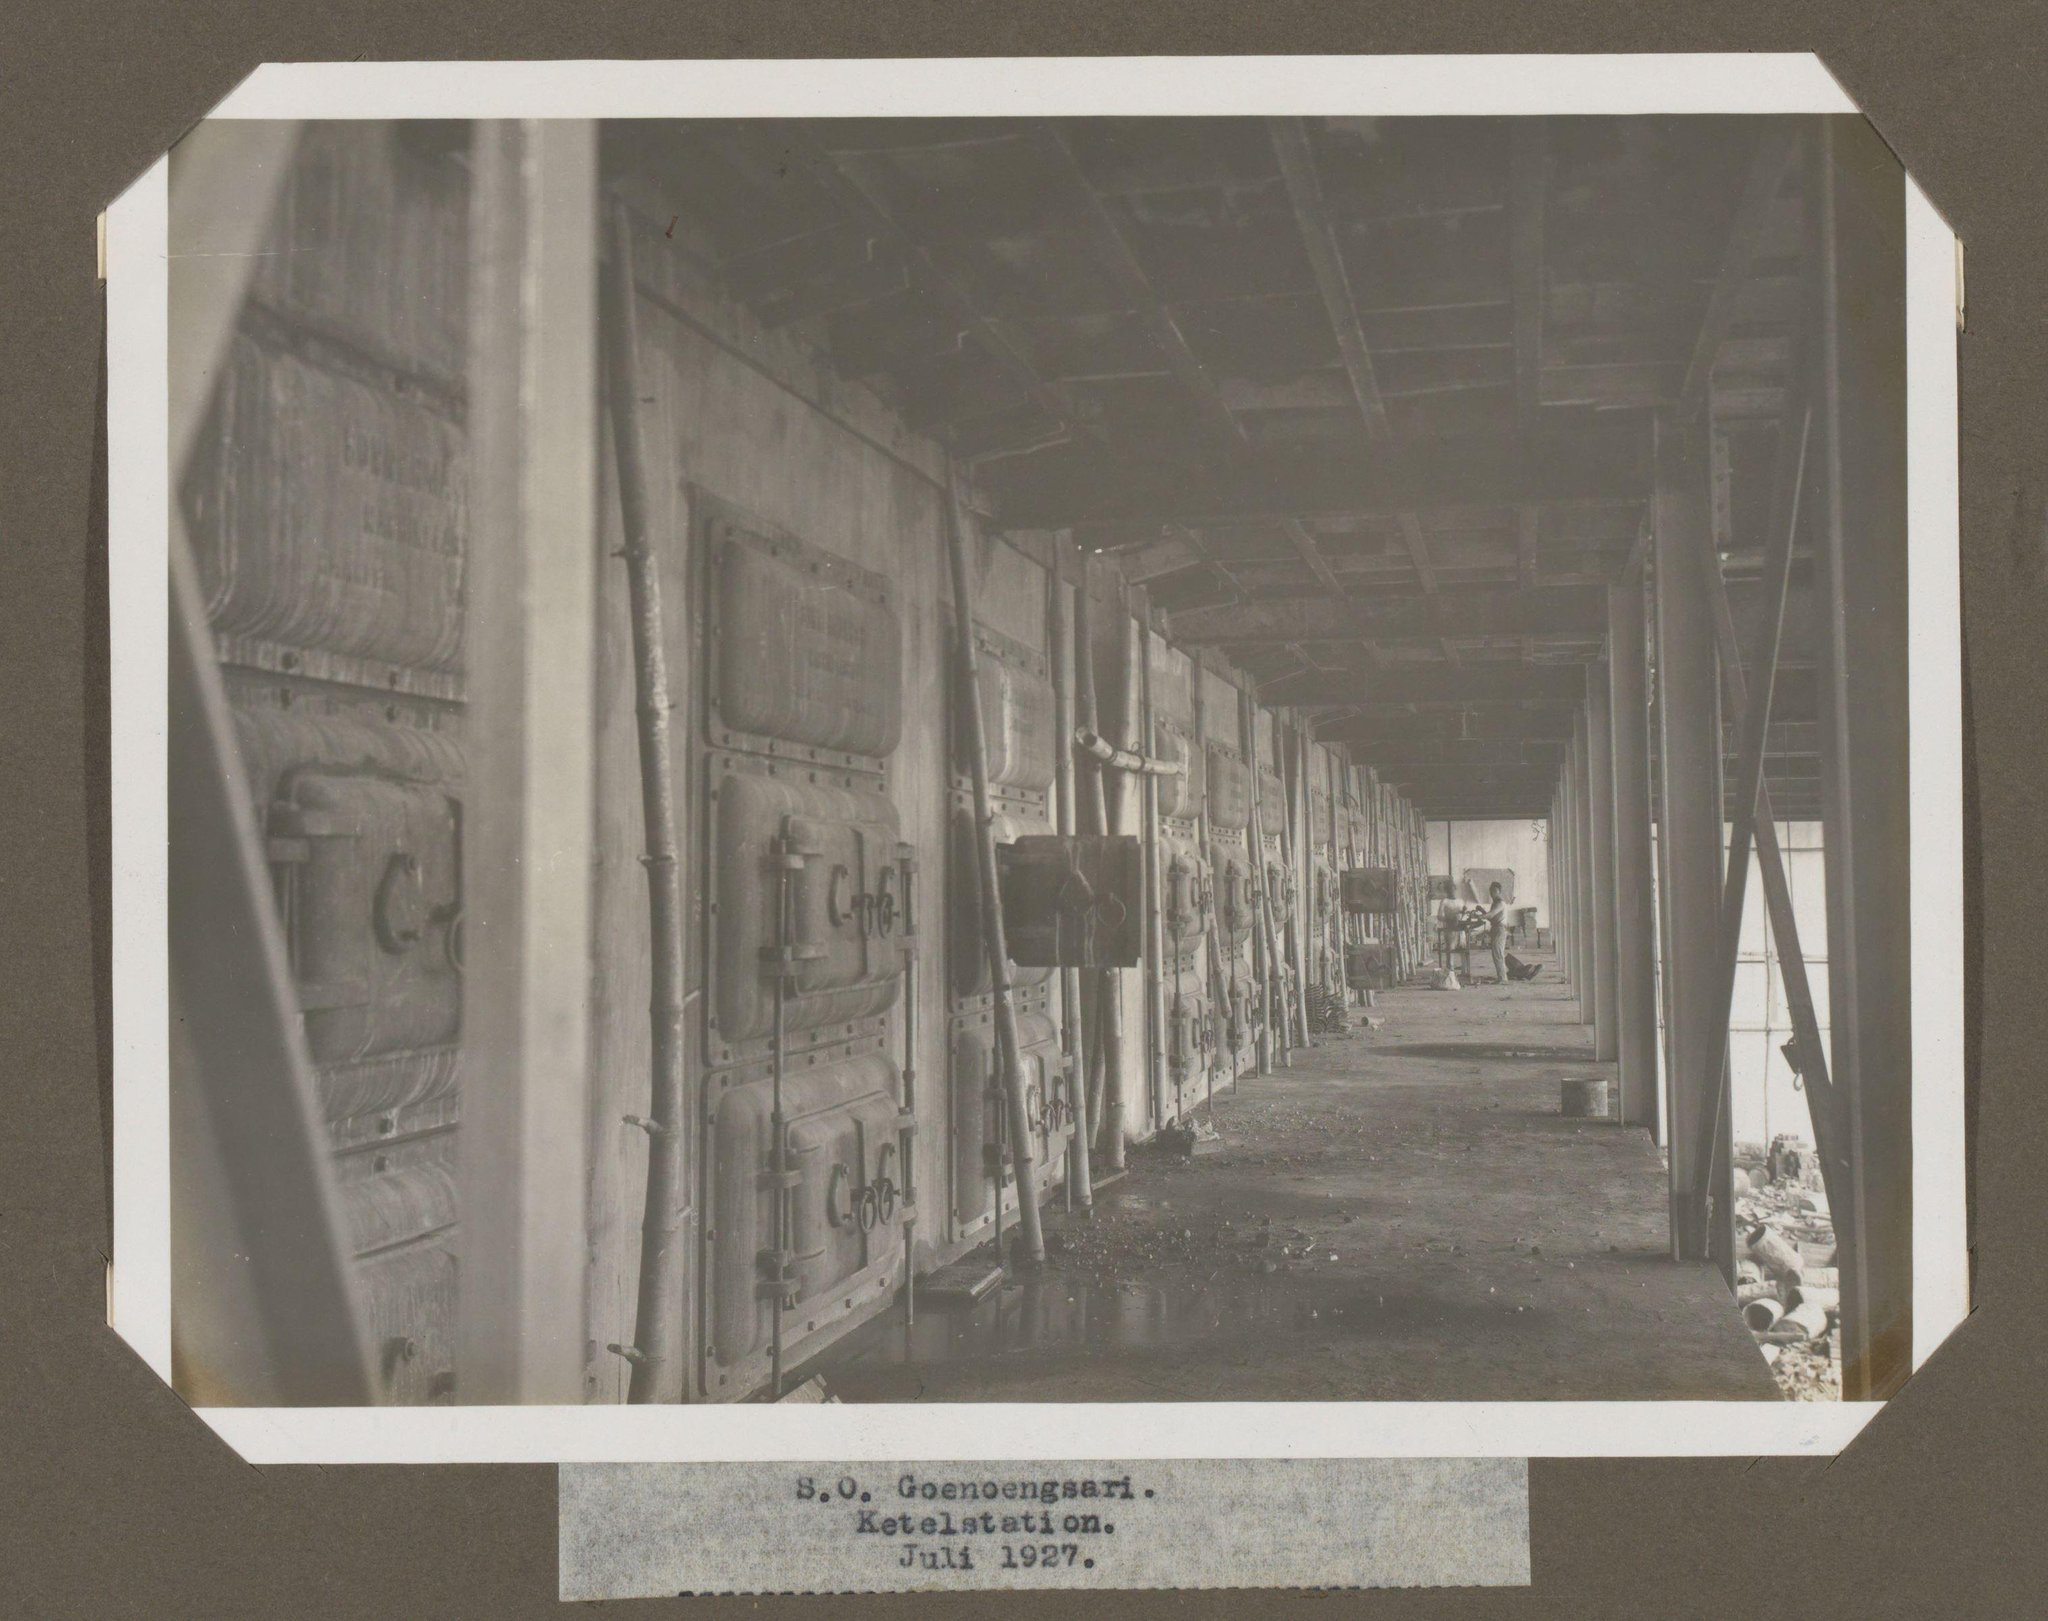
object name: photograph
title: S.O. Goenoengsari. Ketelstation. Juli 1927.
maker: Anonymous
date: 1907-1927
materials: photographic support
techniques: gelatin silver print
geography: east java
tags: colonial system, trade-company, factory-interior, machine shop, making the overground structures (~ building activities), (non-fruit) products of plants or trees: sugarcane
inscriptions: inscription: ‘S.O. Goenoengsari. Ketelstation. Juli 1927.’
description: Geïnstalleerde ketels in de fabriek, juli 1927. Onderdeel van het fotoalbum met foto's van de opbouw van de suikerfabriek te Goenoengsari op Oost-Java door de Handels Vereniging Amsterdam 1926-1927.